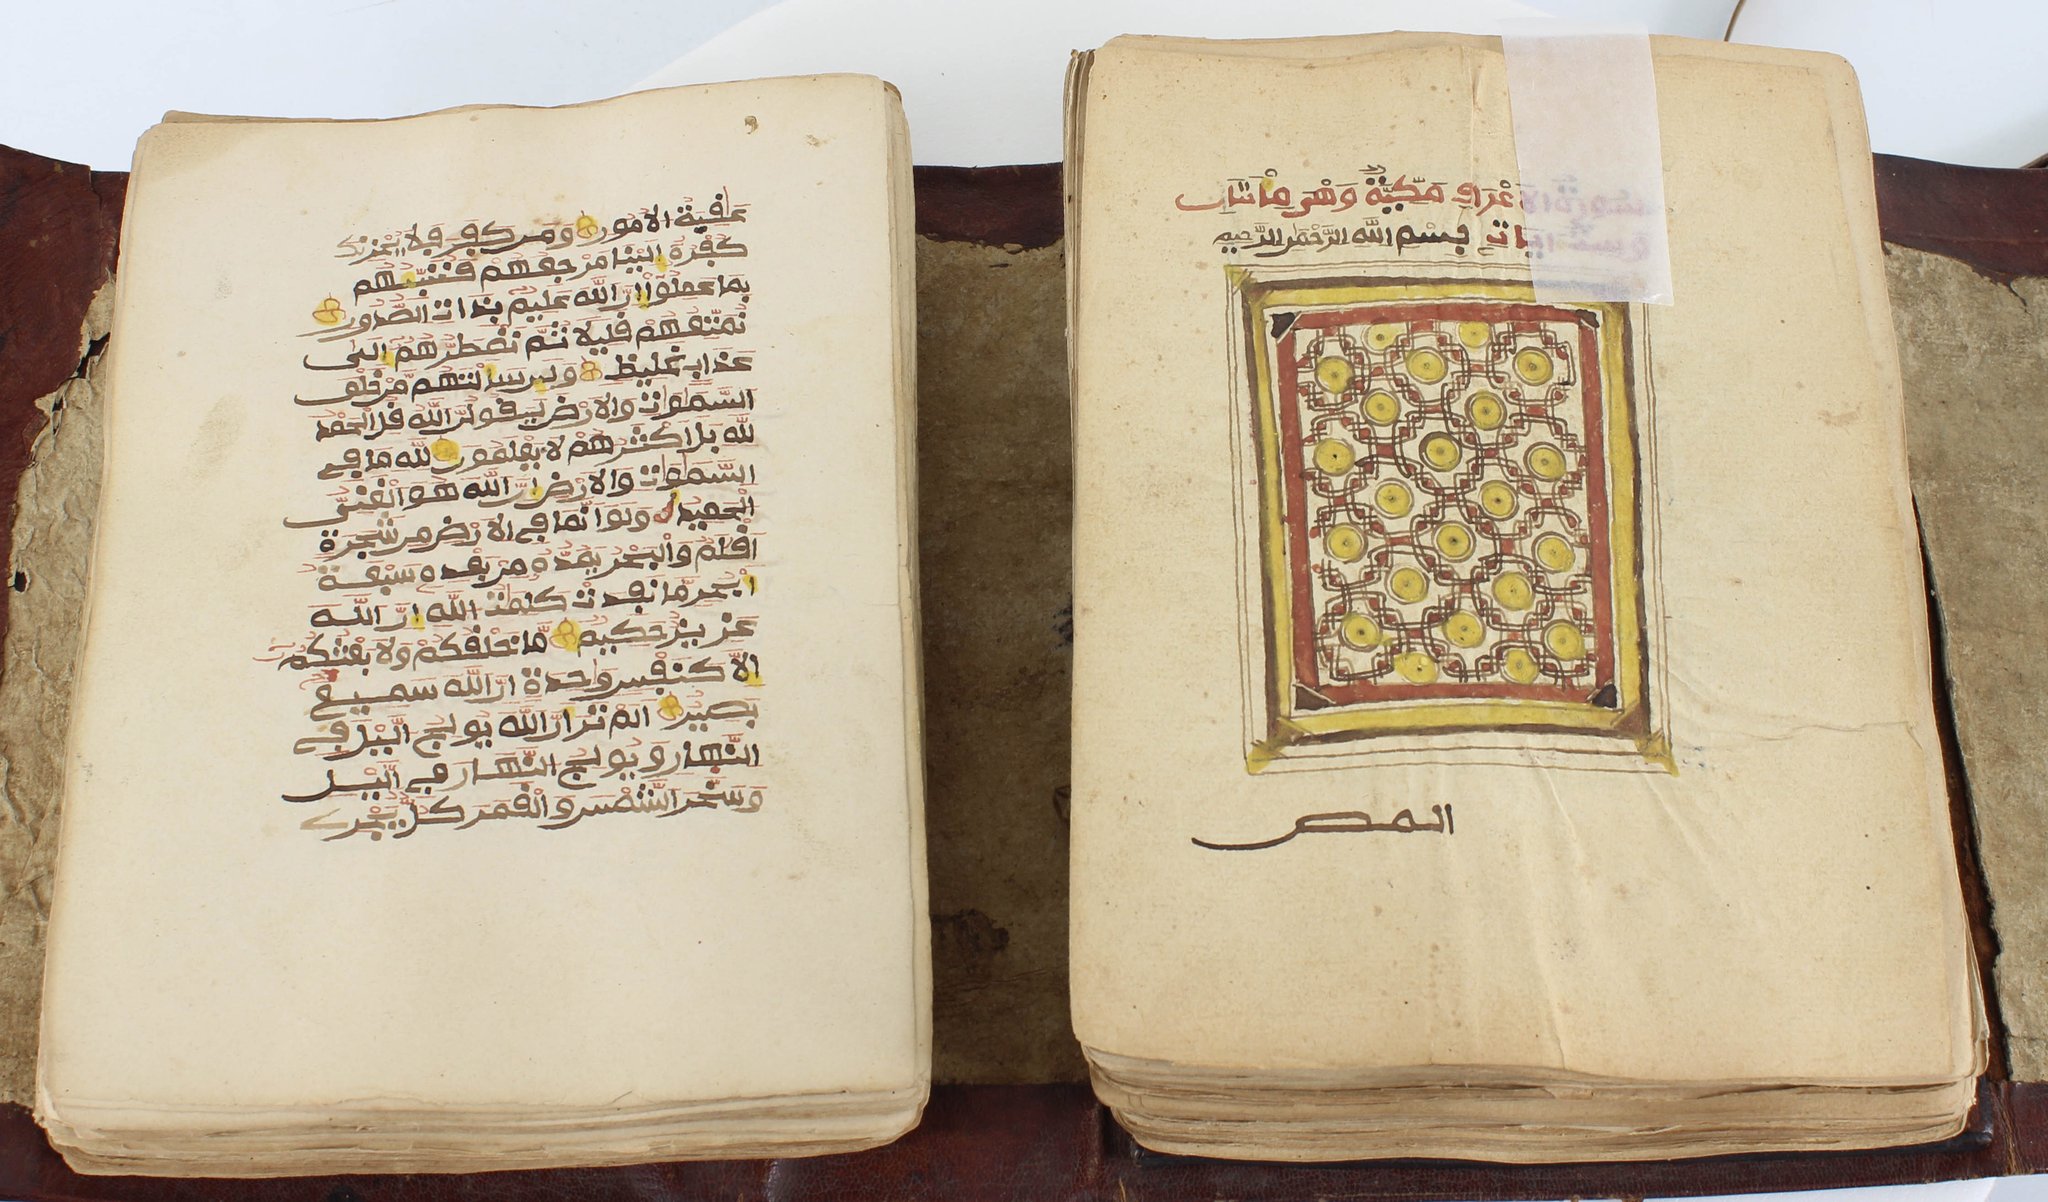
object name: non illustrated manuscript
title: Qur'an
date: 1801-1900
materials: ink, leather, paper, watercolor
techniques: embossing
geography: nigeria